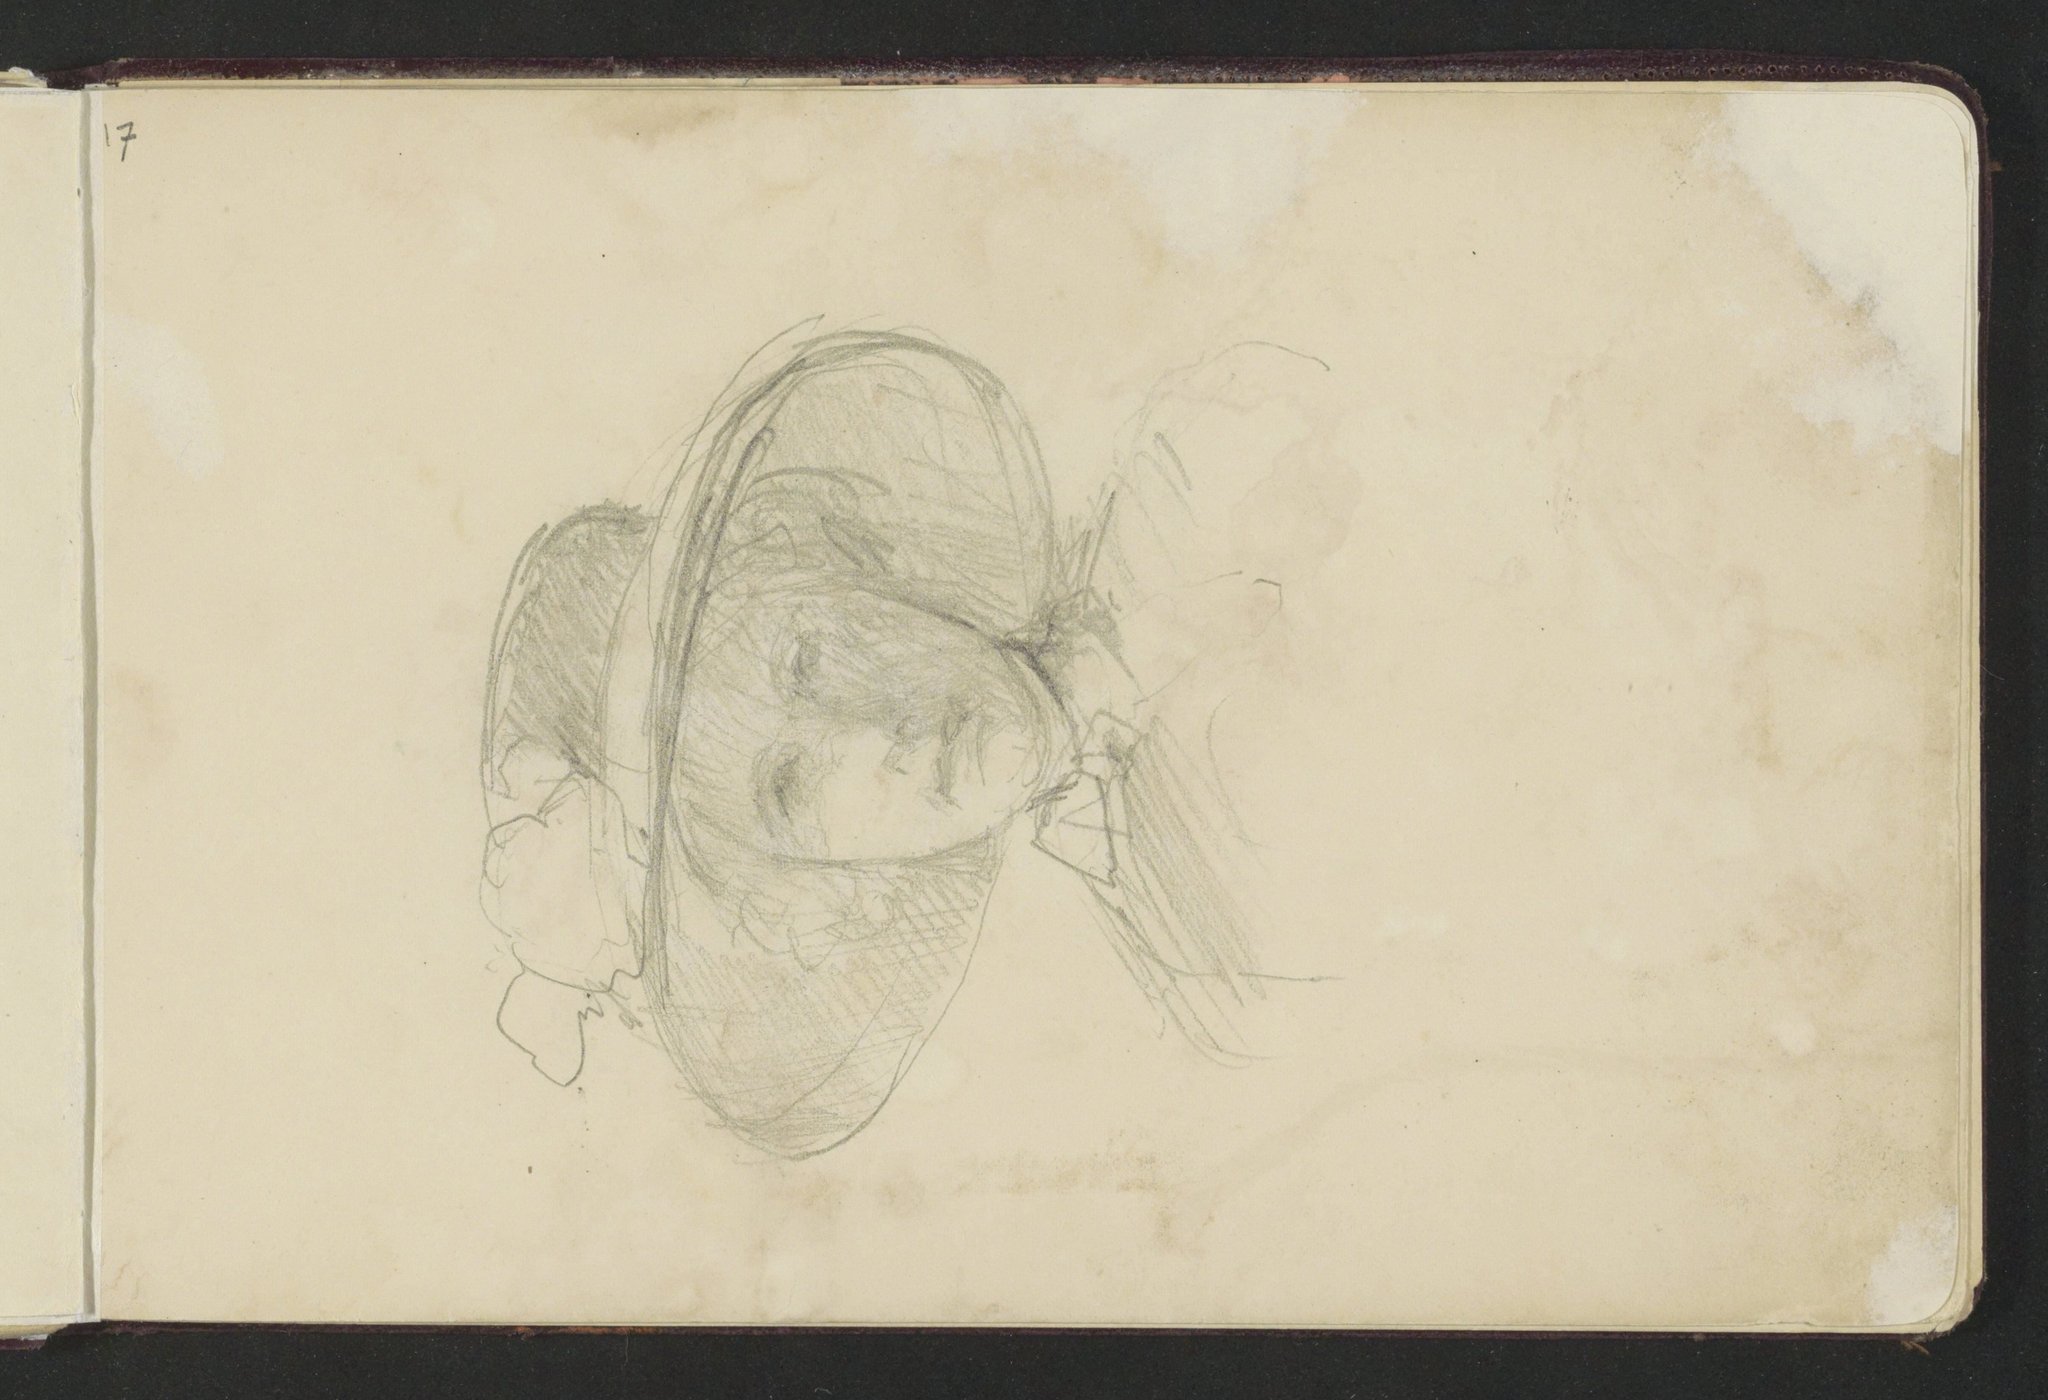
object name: sketchbook leaf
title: Vrouw met een hoed met een strik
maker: jozef israëls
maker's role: draughtsman, painter, print maker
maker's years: 1824-1911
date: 1885-1911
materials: paper, pencil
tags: head (human) (+ female (human being) (not to be used where -aa- is prescribed)), head-gear: hat (+ women's clothes)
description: Blad 17 recto uit een schetsboek met 26 bladen.